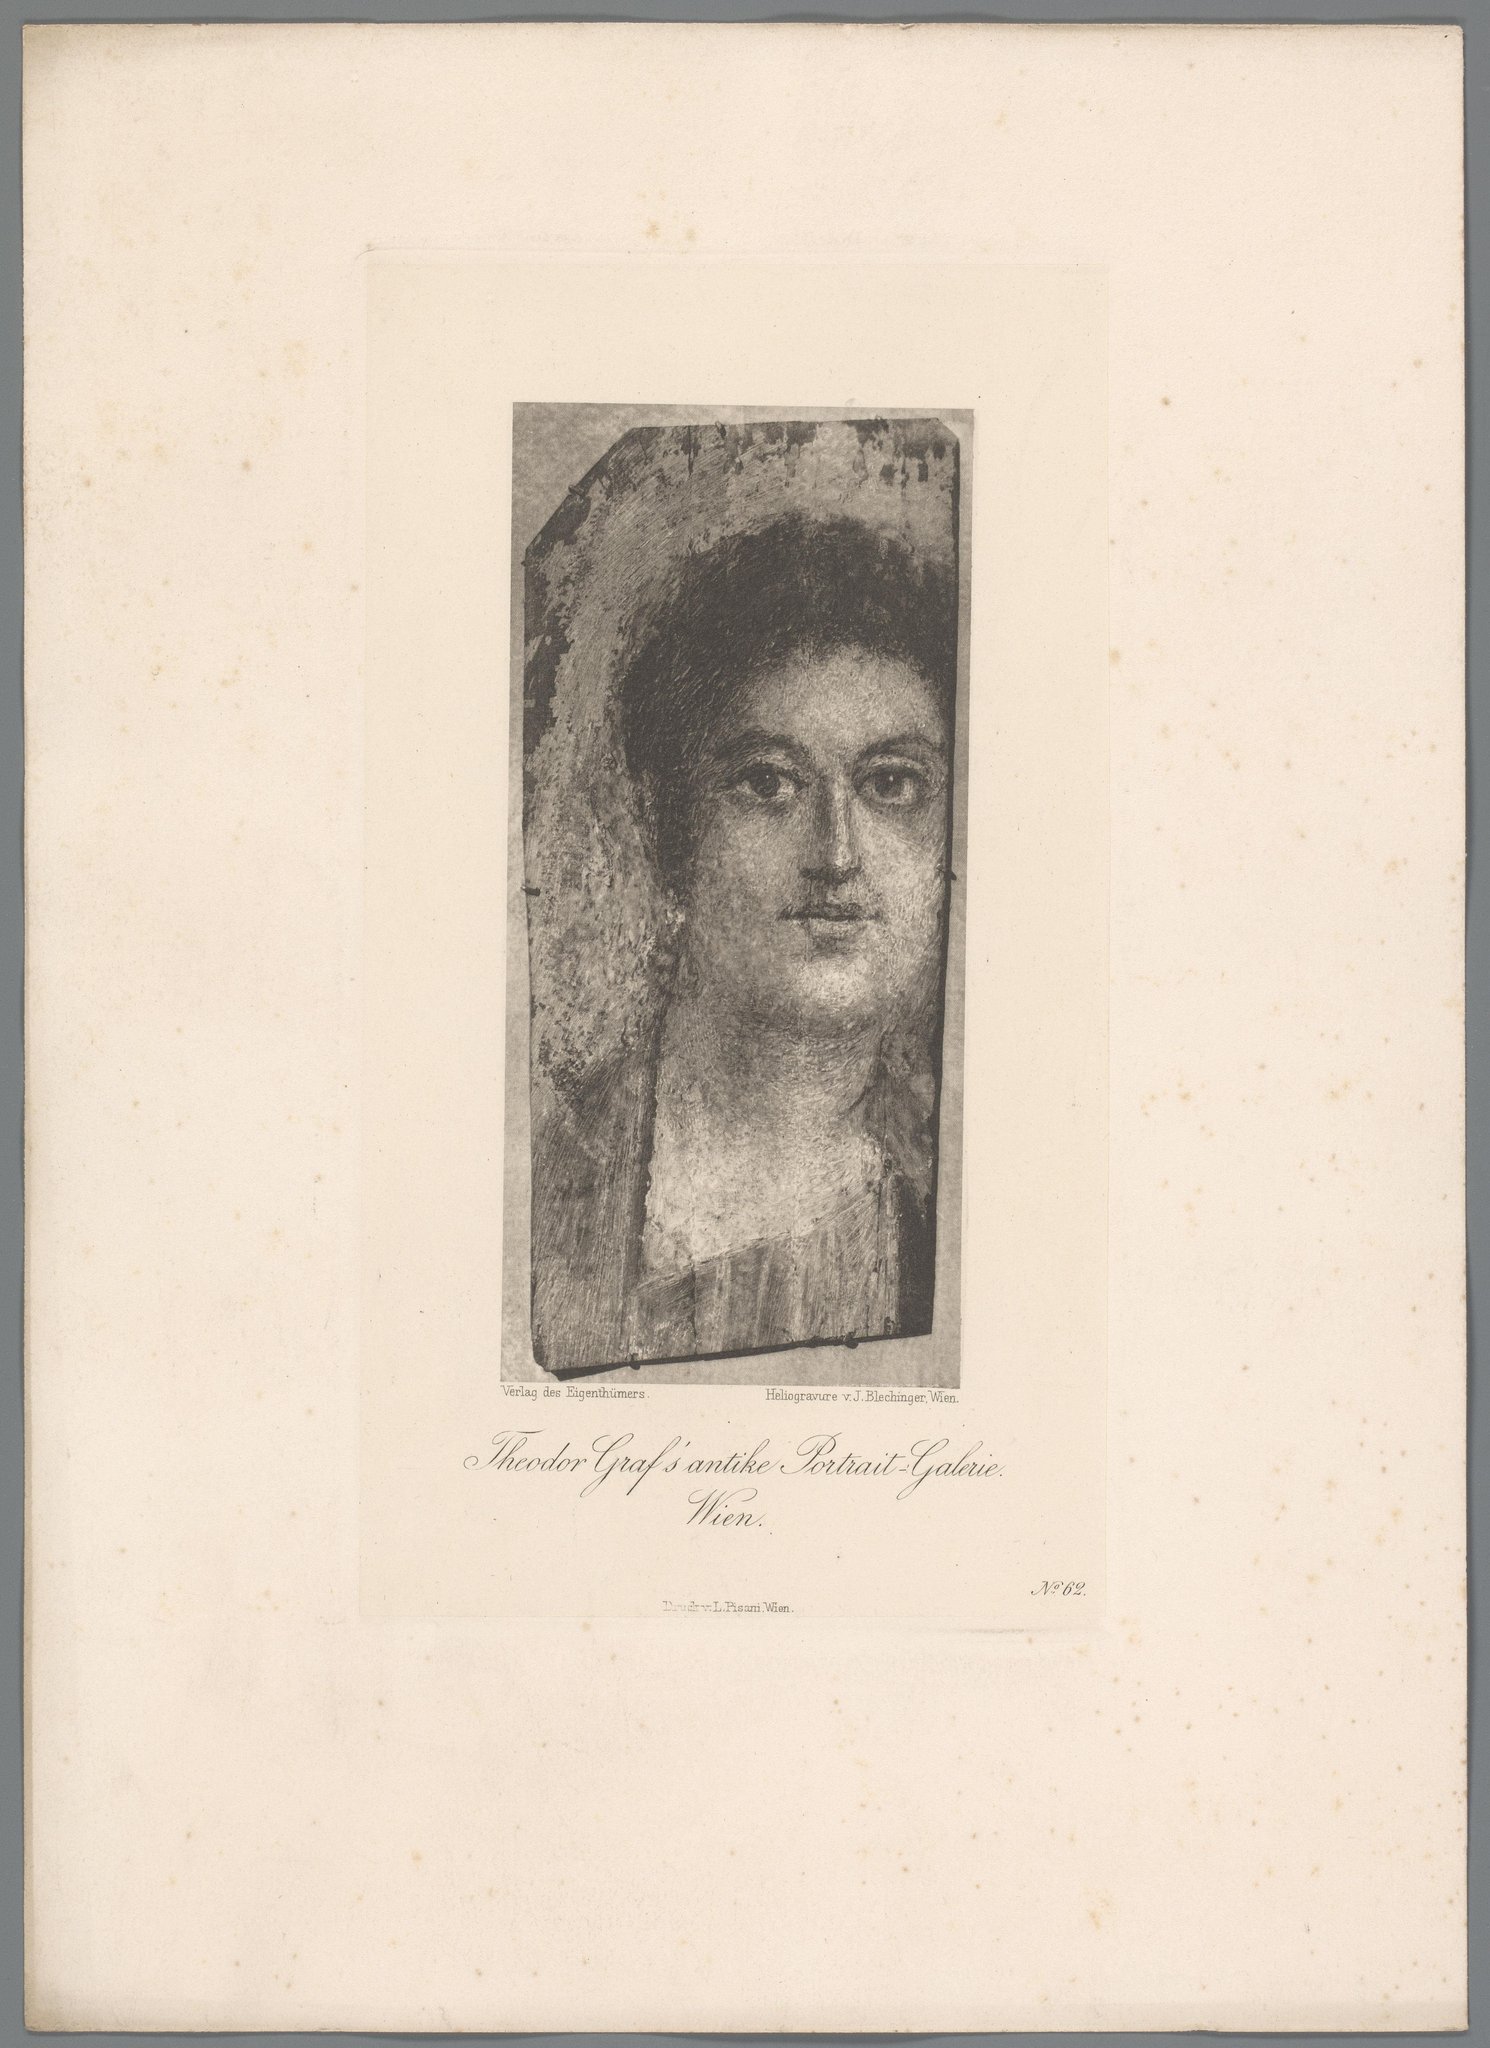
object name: photomechanical print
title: Theodor Graf's antike Portrait-Galerie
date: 1860-1890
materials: paper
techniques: photoaquatint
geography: vienna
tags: historical persons not known by name - bb - woman, picture, painting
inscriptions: inscription: ‘Verlag des Eigenthümers/ No. 62’